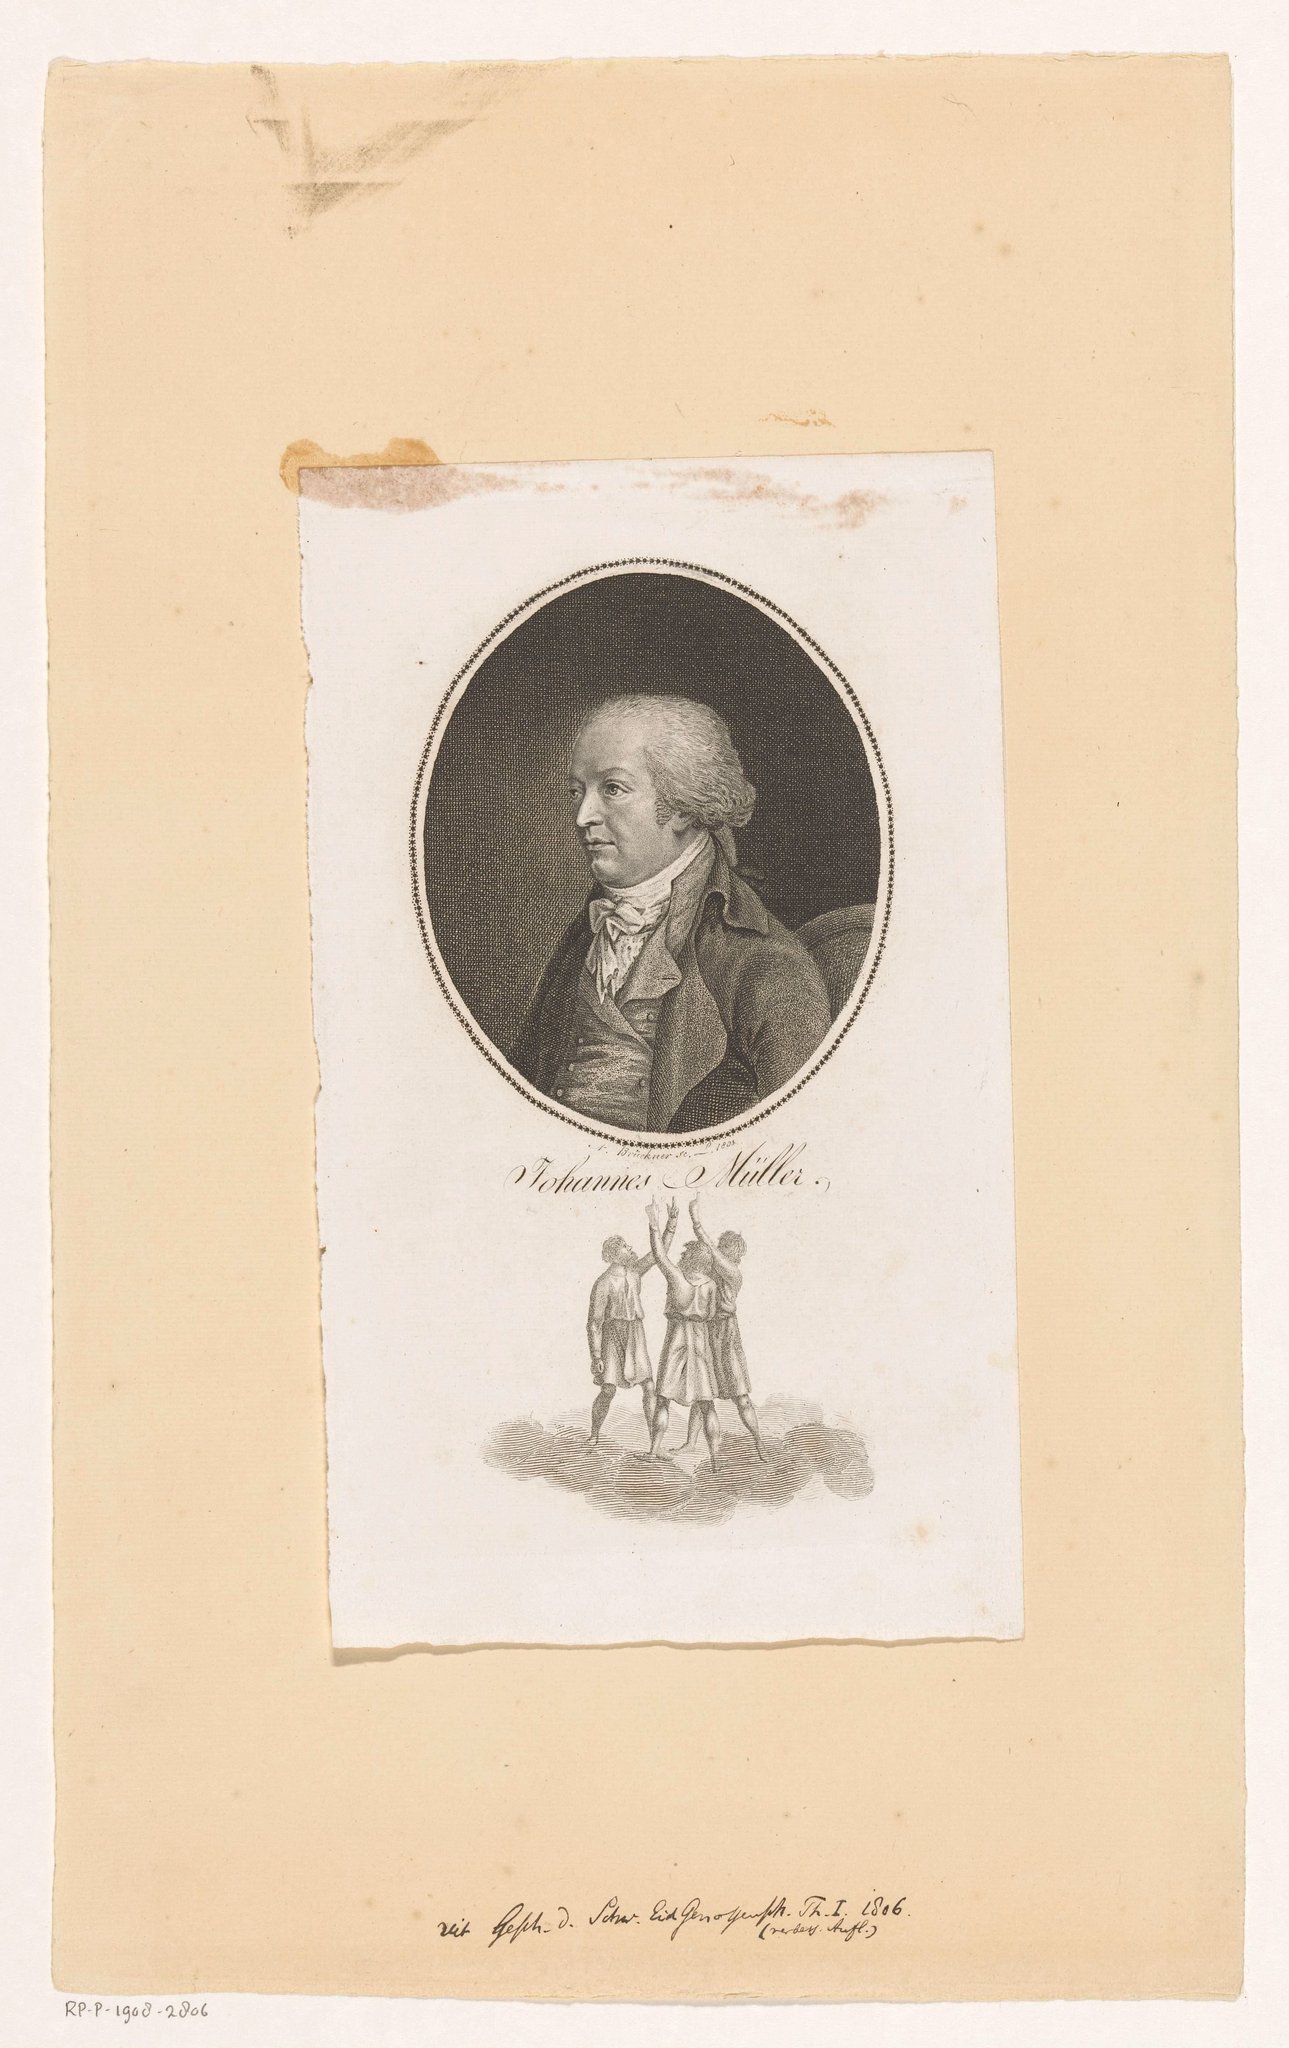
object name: print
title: Portret van Johannes Müller von Sylvelden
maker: friedrich august brückner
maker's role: print maker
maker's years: 1785-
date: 1805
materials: paper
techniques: engraving, etching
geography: leipzig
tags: historical persons, sitting or standing on clouds, index finger forwards, pointing, indicating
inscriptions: collector's mark: Lugt 2228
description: Prent mogelijk ook gebruikt in: Geschichte der Schweizerischen Eidgenossenschaft, 1806.